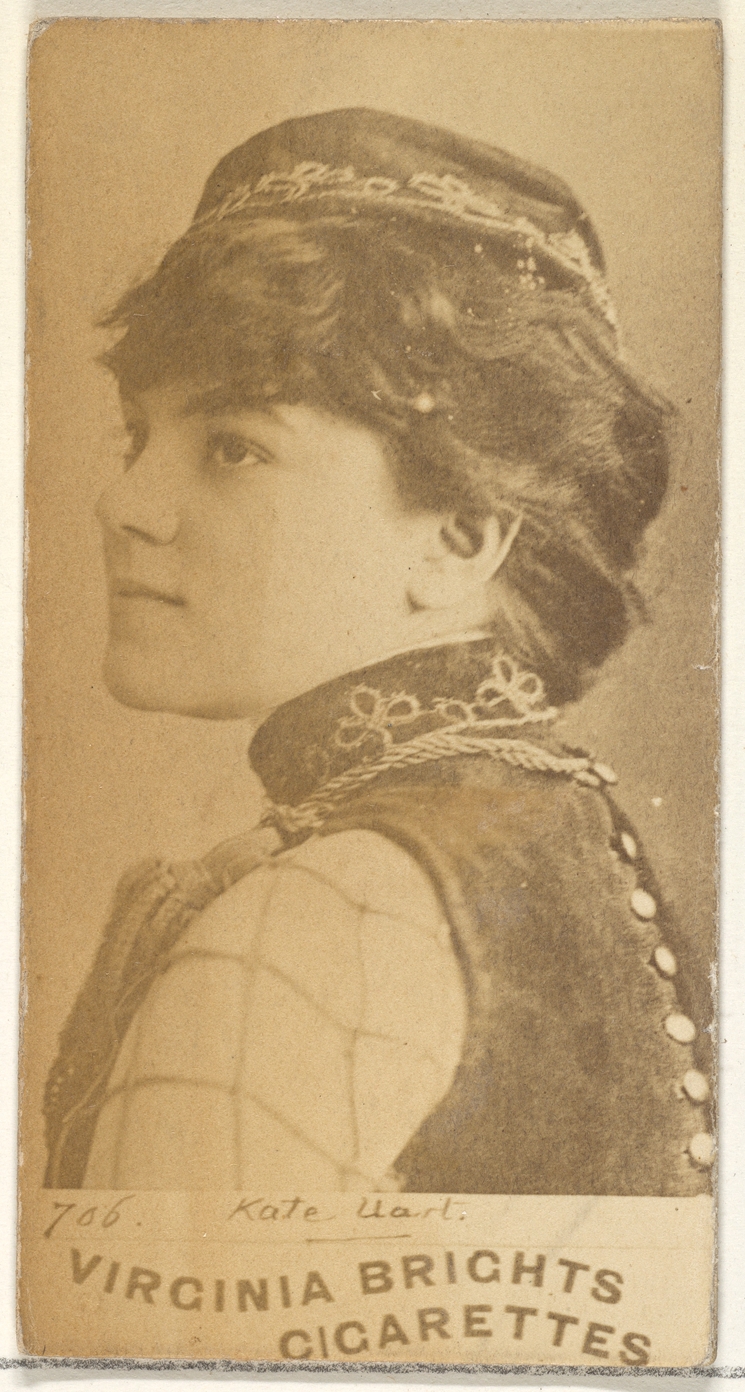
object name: photograph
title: Card 706, Kate Uart, from the Actors and Actresses series (N45, Type 1) for Virginia Brights Cigarettes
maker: allen & ginter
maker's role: publisher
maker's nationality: american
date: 1888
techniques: albumen silver print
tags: portraits,women,actresses